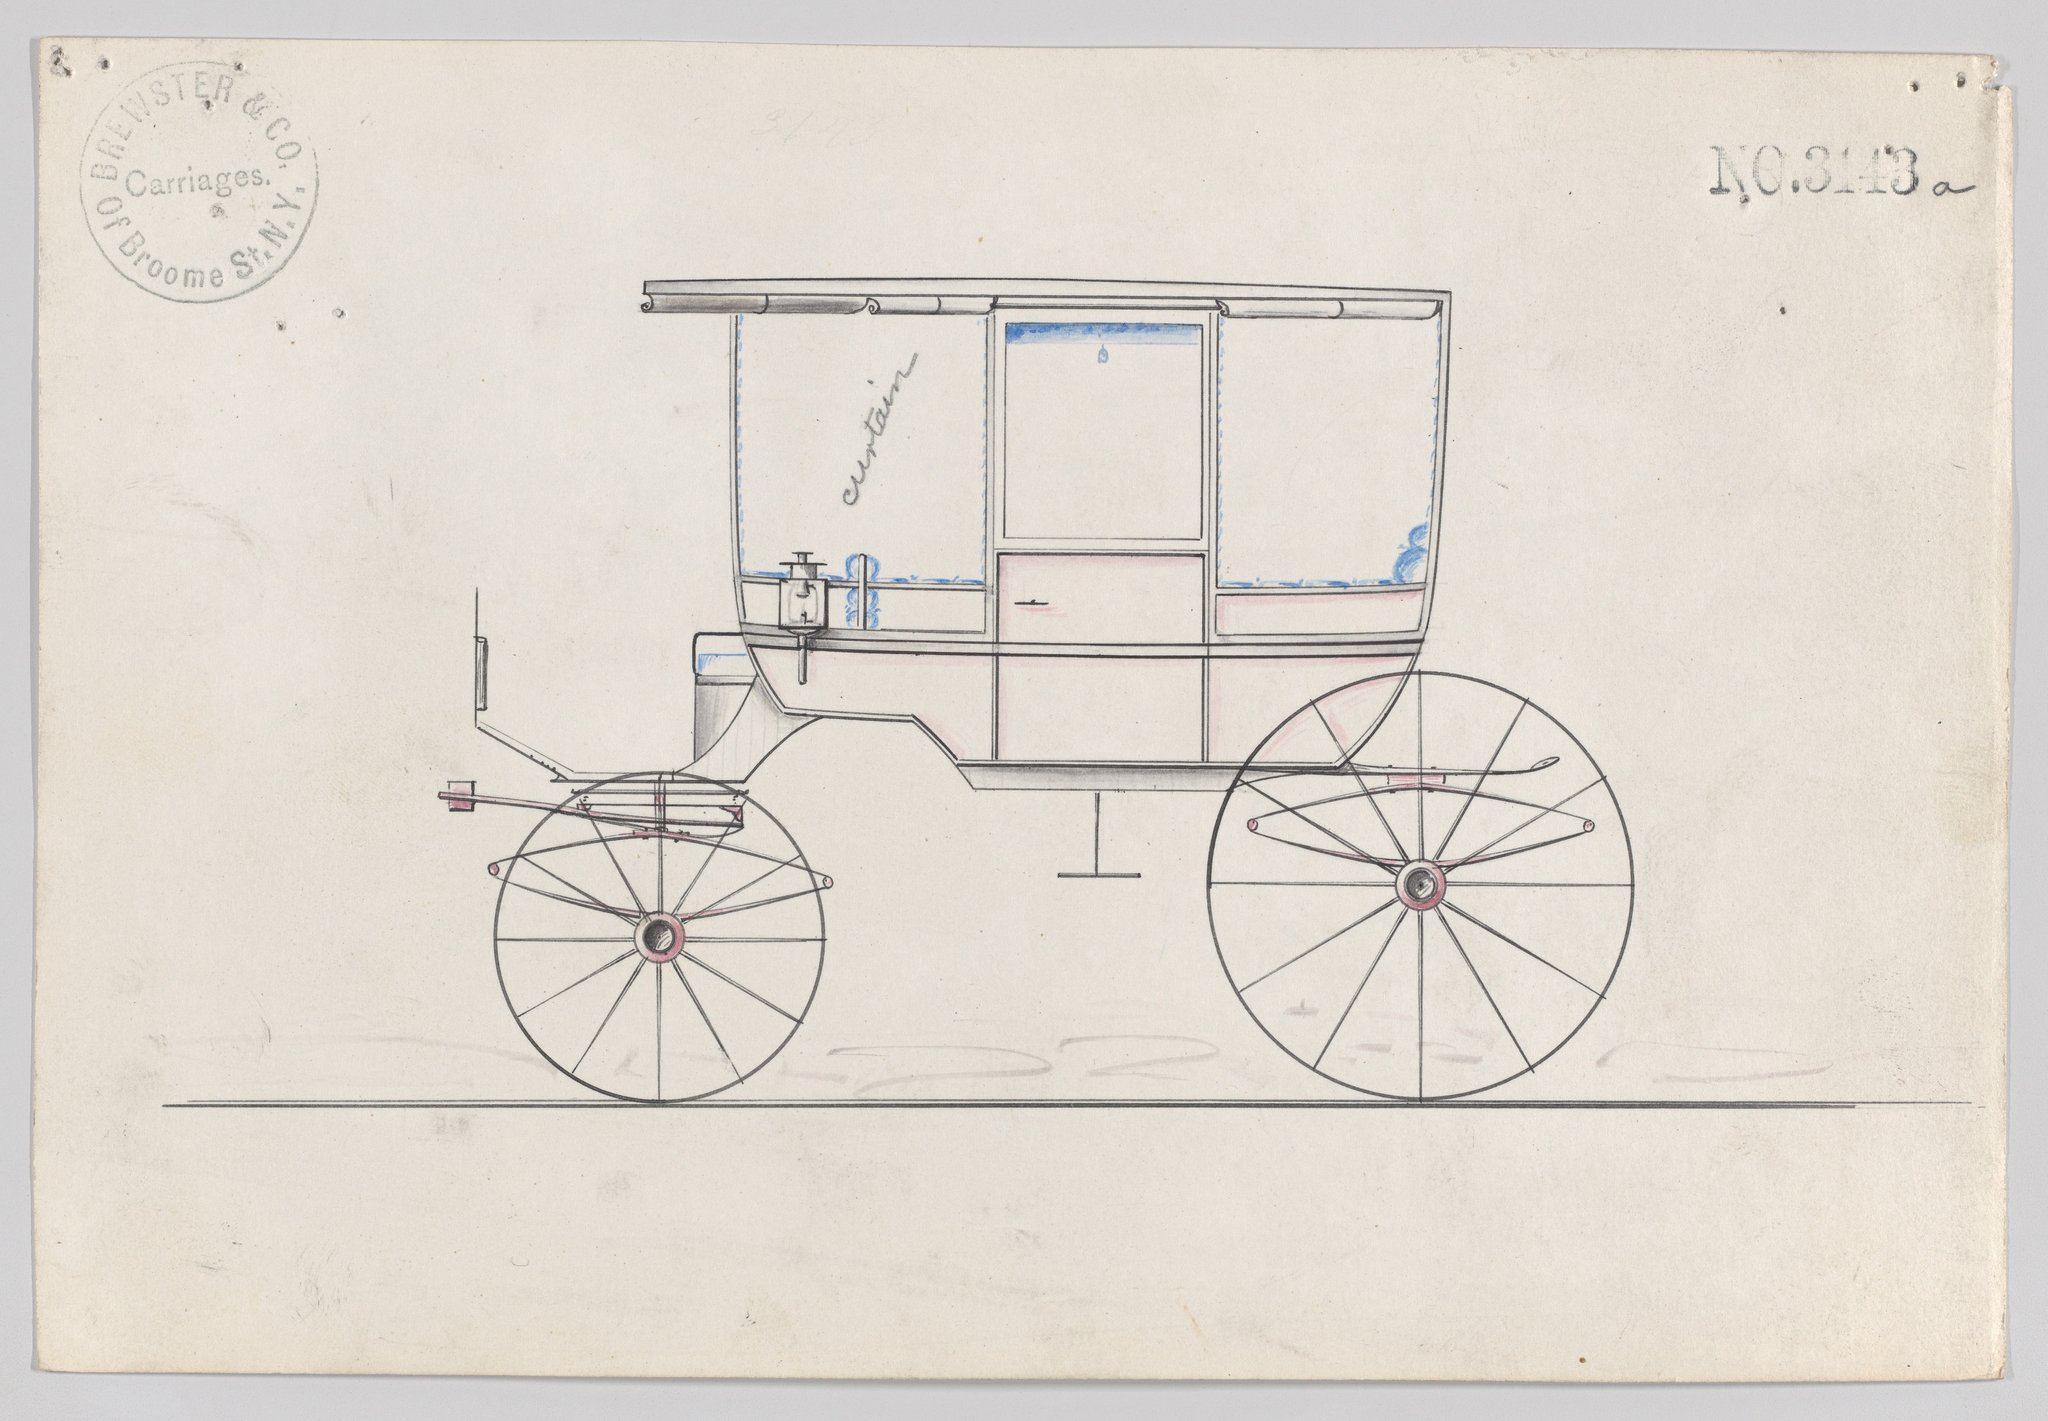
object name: drawing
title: Design for 6 seat Rockaway, no. 3143a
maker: brewster & co.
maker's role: manufacturer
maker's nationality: american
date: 1875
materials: gouache, ink, watercolor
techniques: pen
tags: carriages